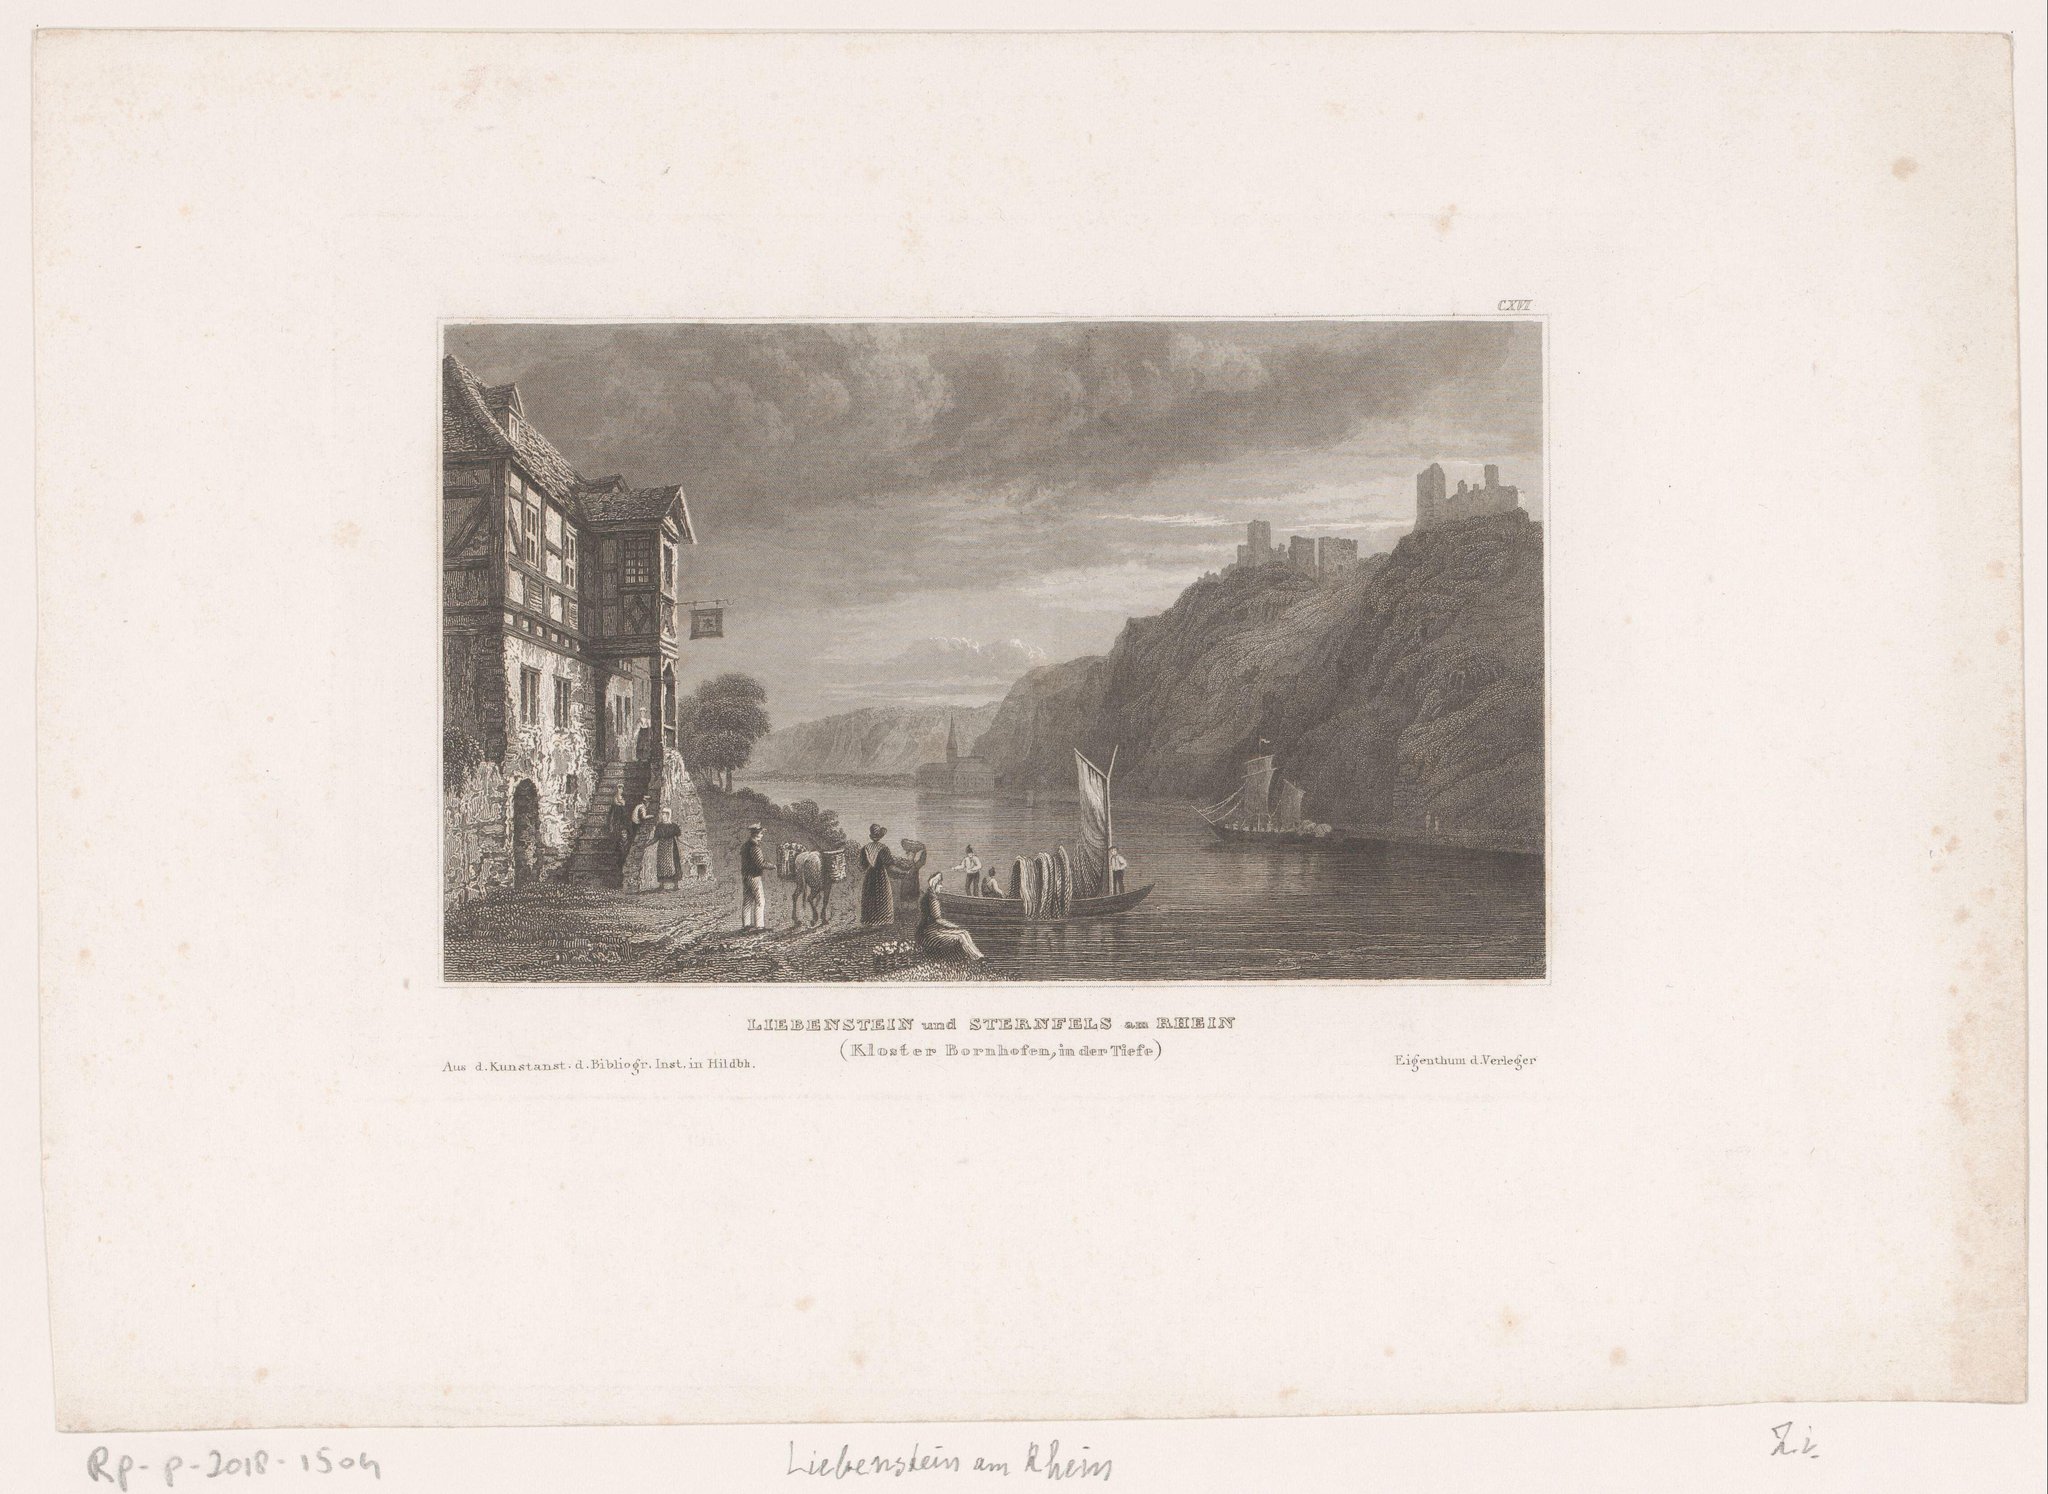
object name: print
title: Liebenstein und Sternfels am Rhein (Kloster Bornhofen, in der Tiefe)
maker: Anonymous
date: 1828-1874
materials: paper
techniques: engraving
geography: hildburghausen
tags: castle, river, abbey, monastery, convent ~ roman catholic church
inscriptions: collector's mark: Lugt 2228